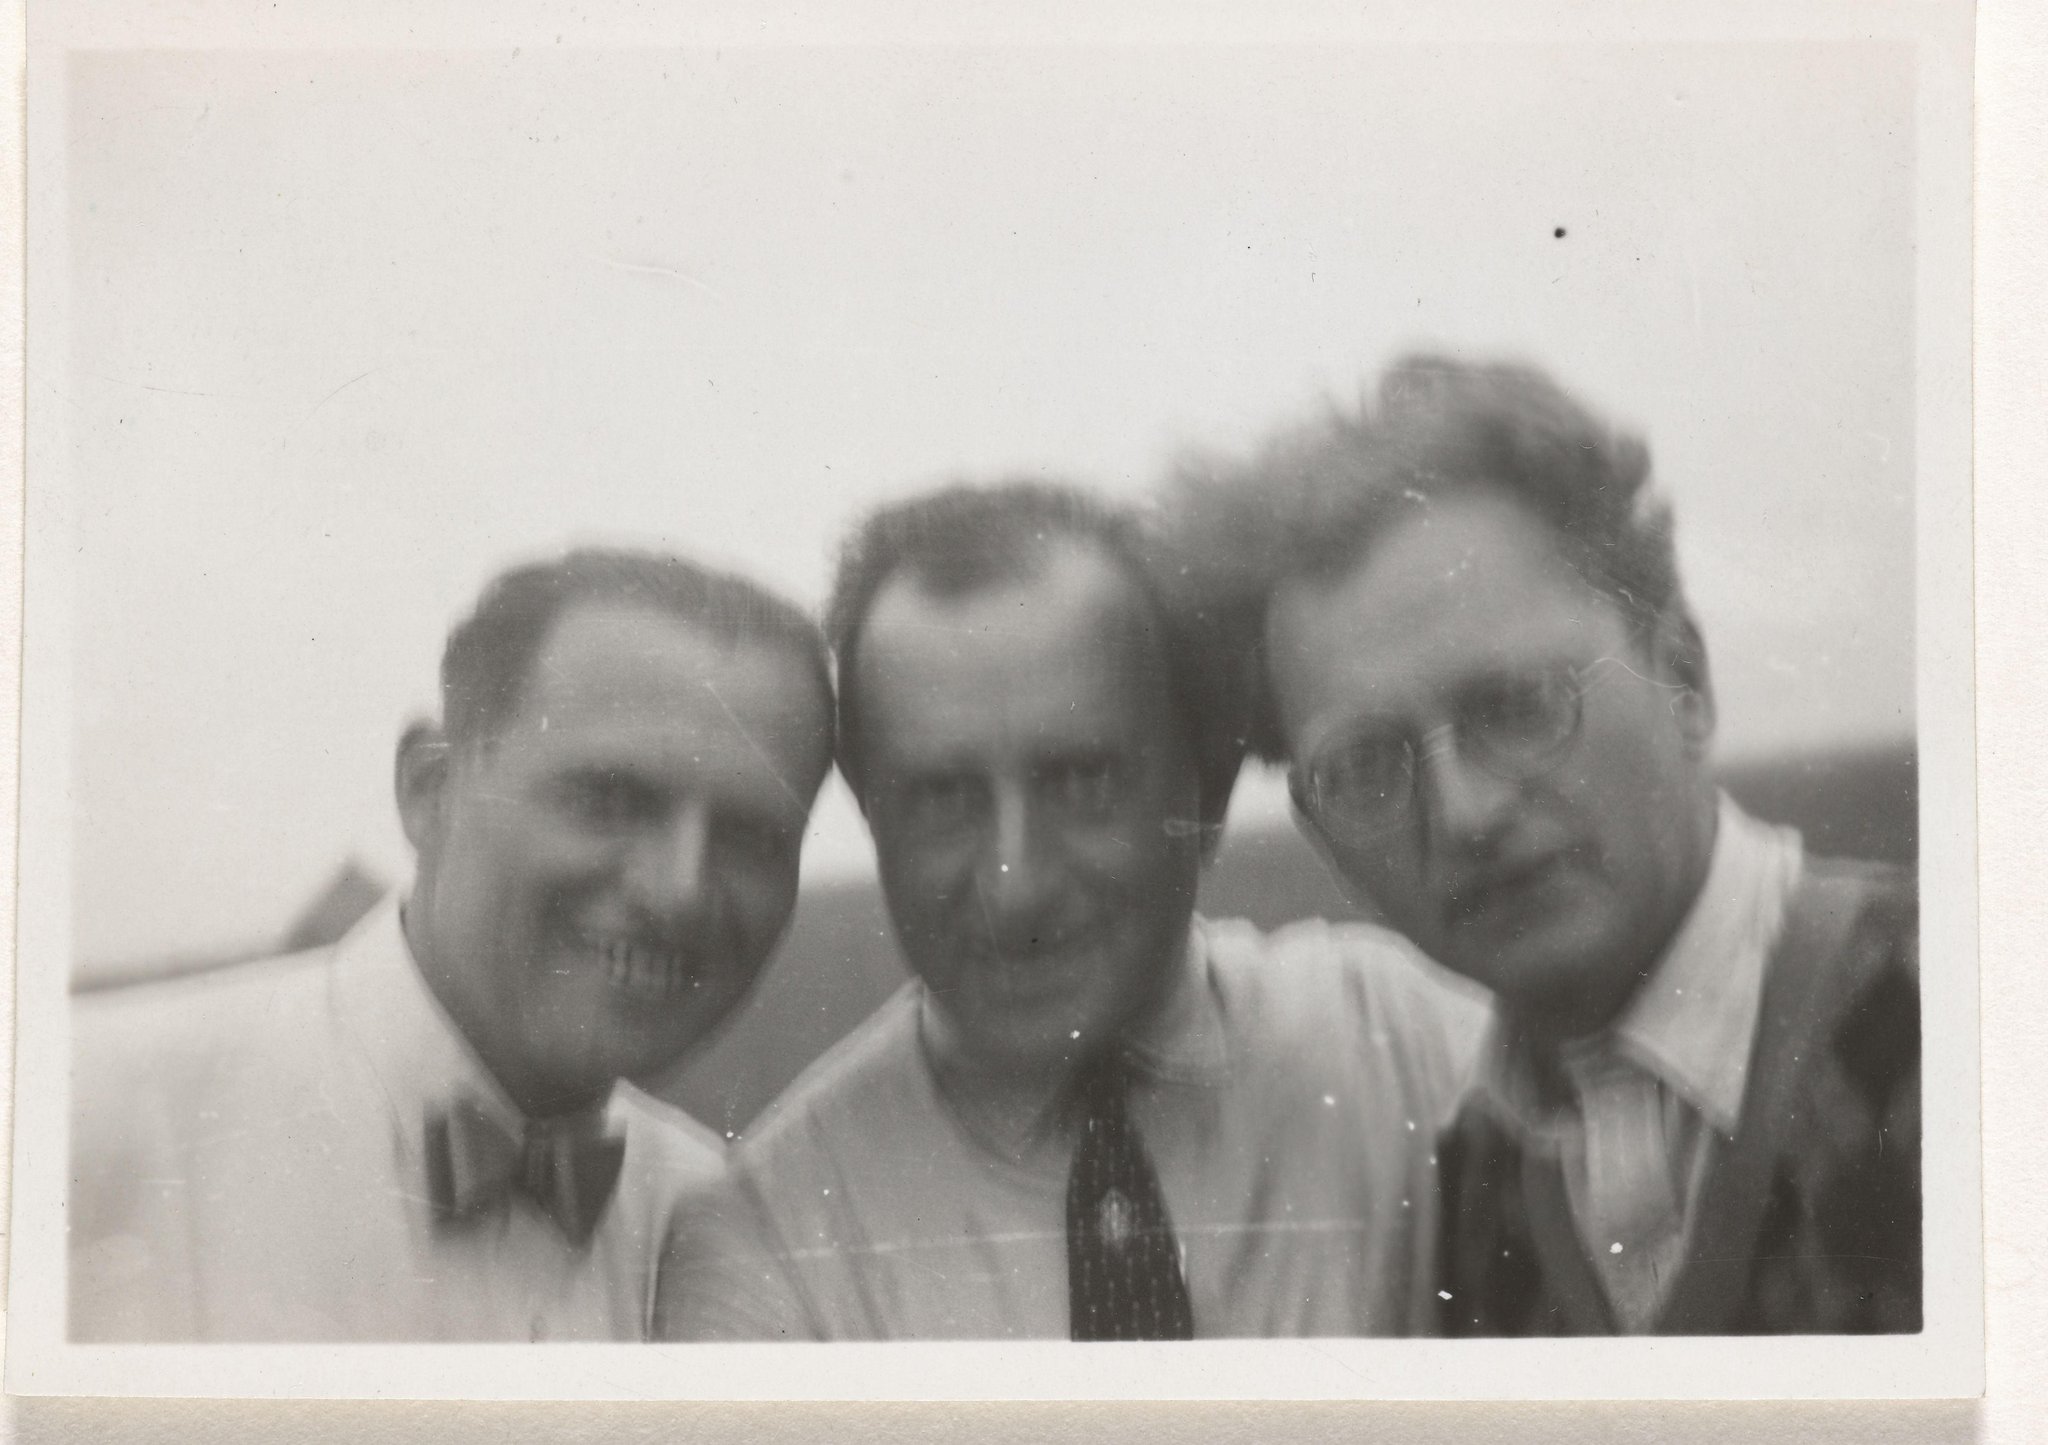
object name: photograph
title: Groepsportret van Karl With en twee onbekende mannen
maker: Anonymous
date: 1920-1936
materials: paper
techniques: gelatin silver print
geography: germany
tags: karl with, historical person (with name) - historical person (with name) portrayed in a group, in a group-portrait, friends, germany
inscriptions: factory mark: ‘Agfa Lupex’